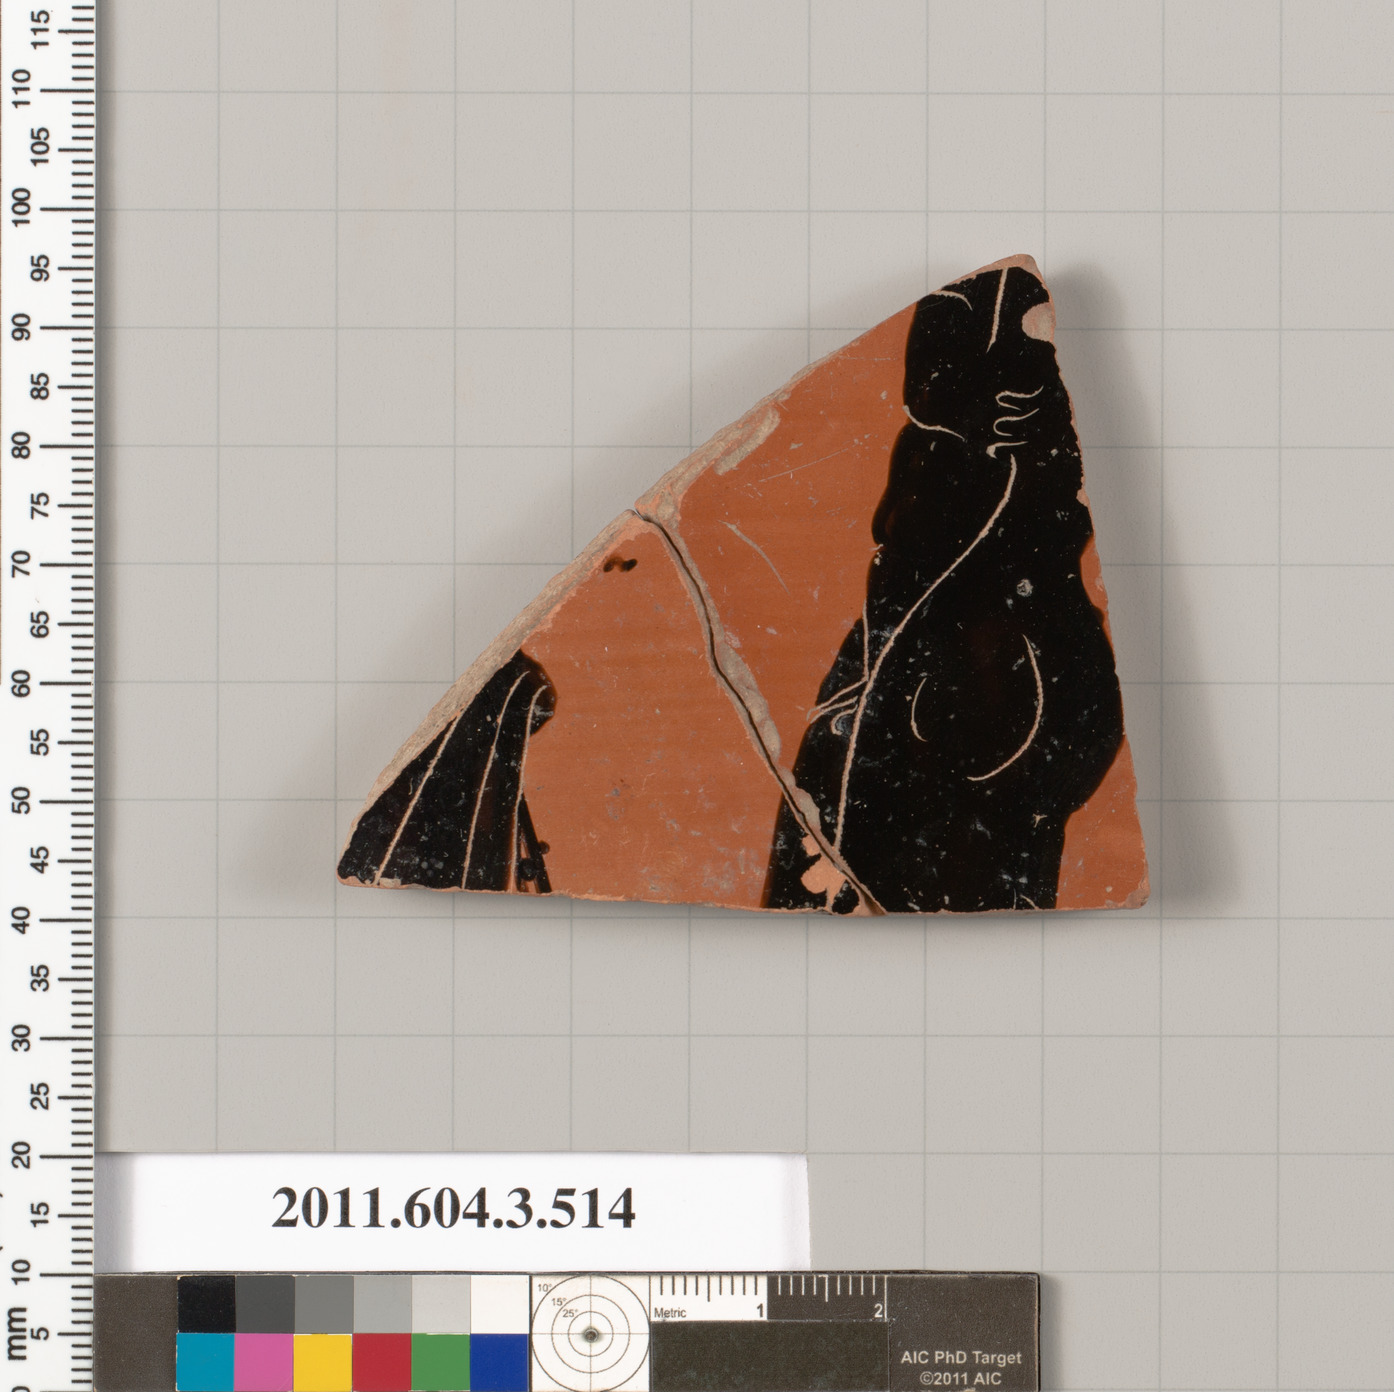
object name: column krater fragment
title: Terracotta fragment of a column-krater (bowl for mixing wine and water)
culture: greek, attic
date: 534-468 BCE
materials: terracotta